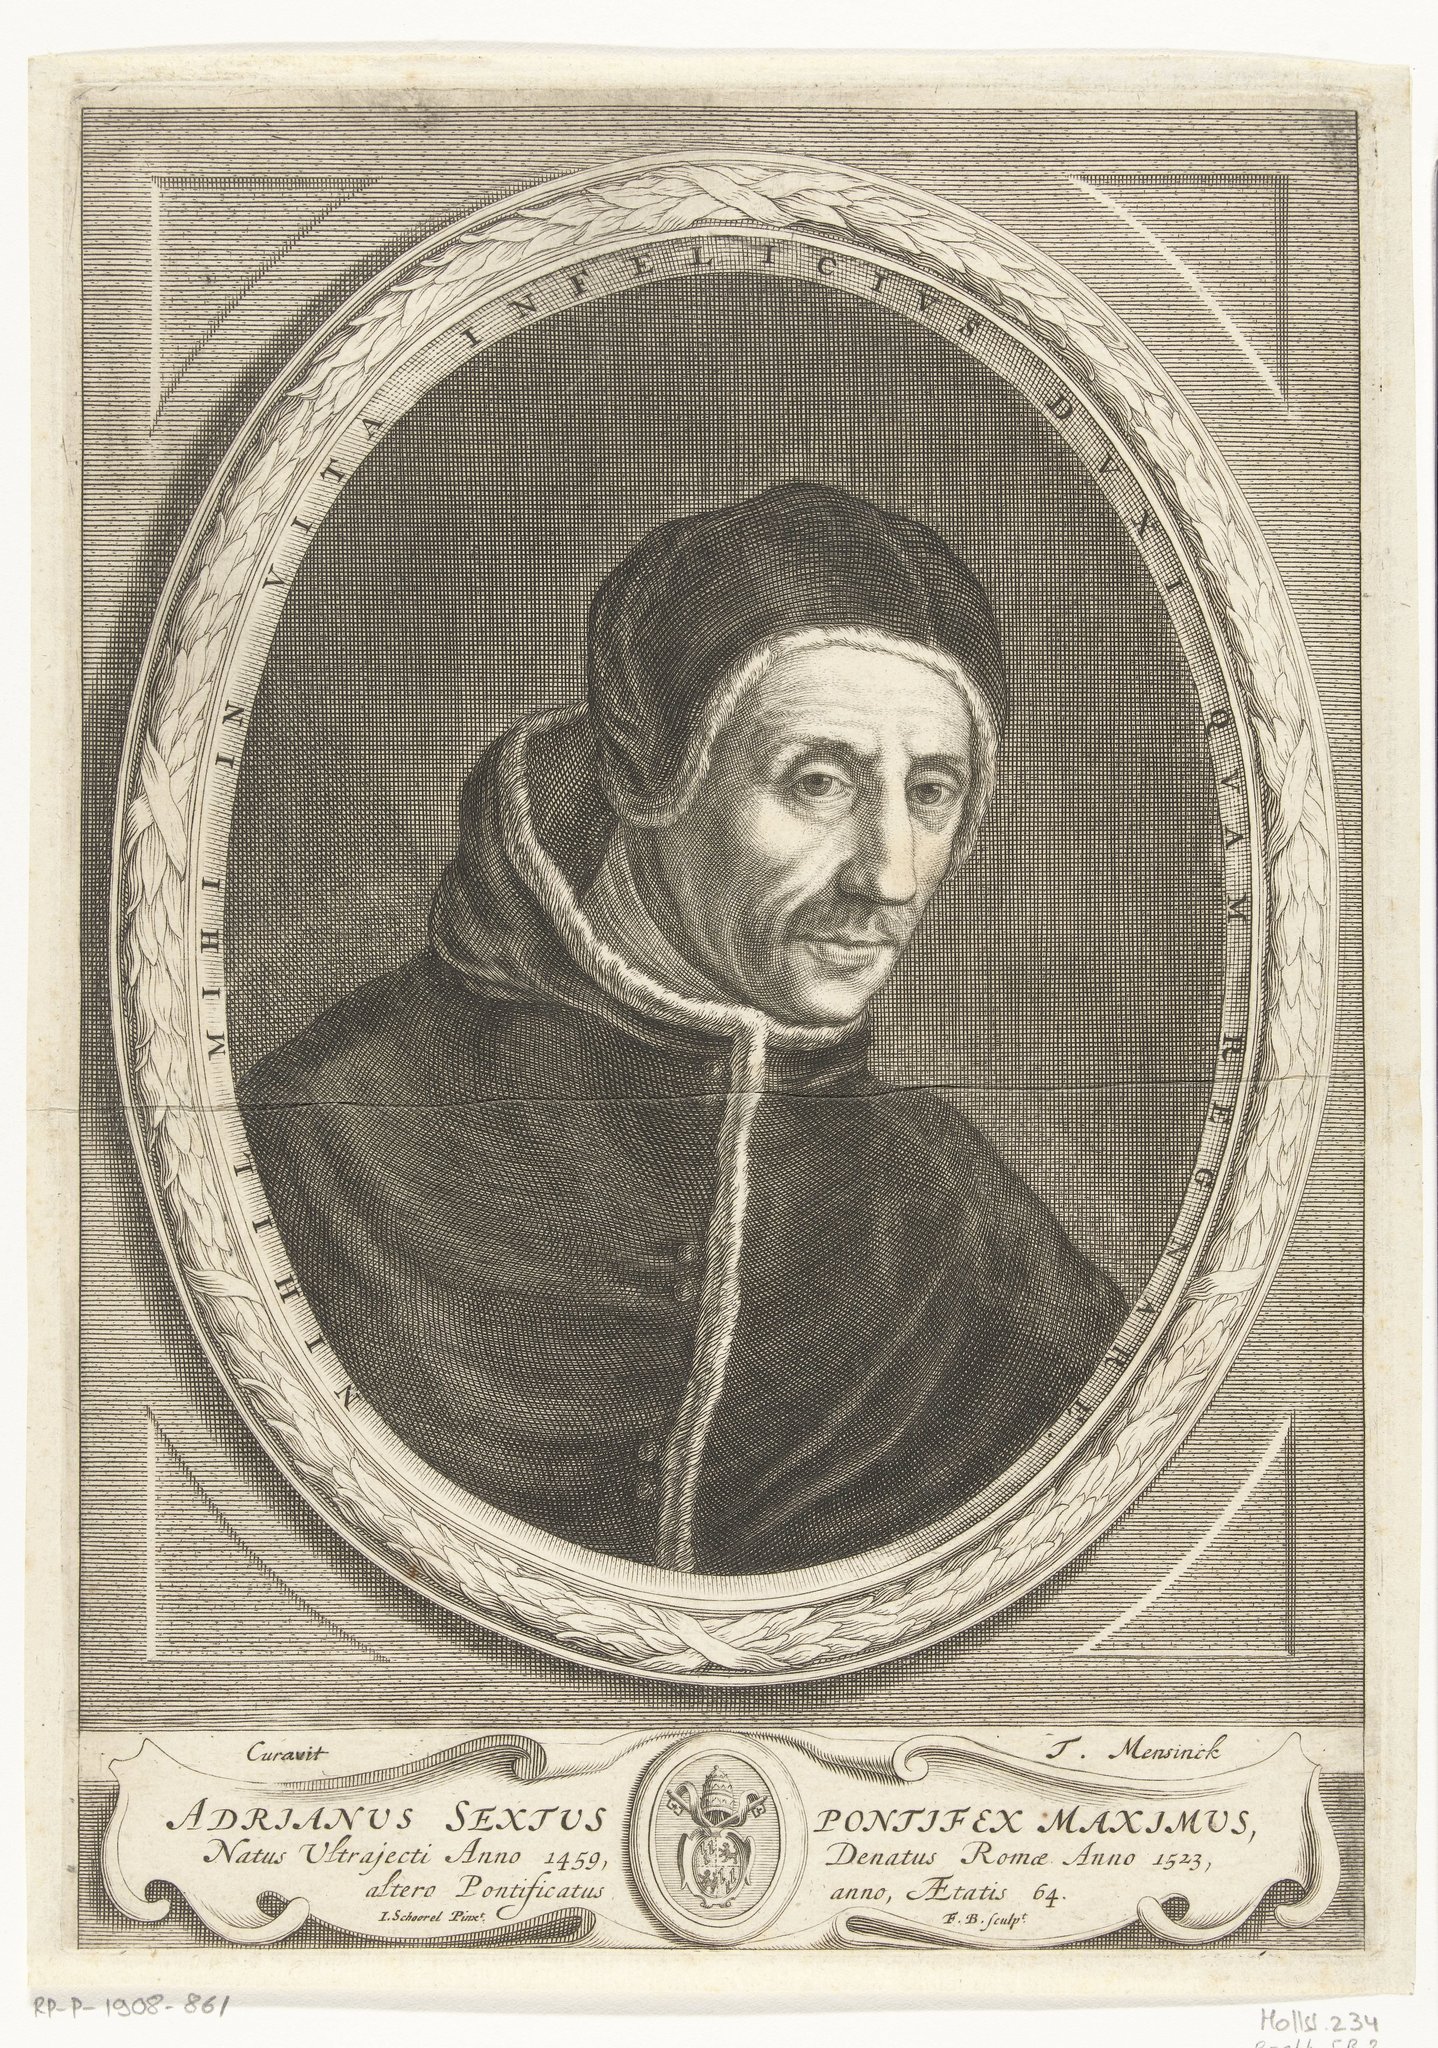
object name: print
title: Portret van Paus Adrianus VI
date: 1653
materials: paper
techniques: engraving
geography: netherlands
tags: rome, pope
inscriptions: collector's mark: Lugt 2228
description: Portret van paus Adrianus VI in ovaal, omlijst met palmbladeren en Latijnse randtekst. Onder het portret zijn pauselijk wapen en een Latijns onderschrift.